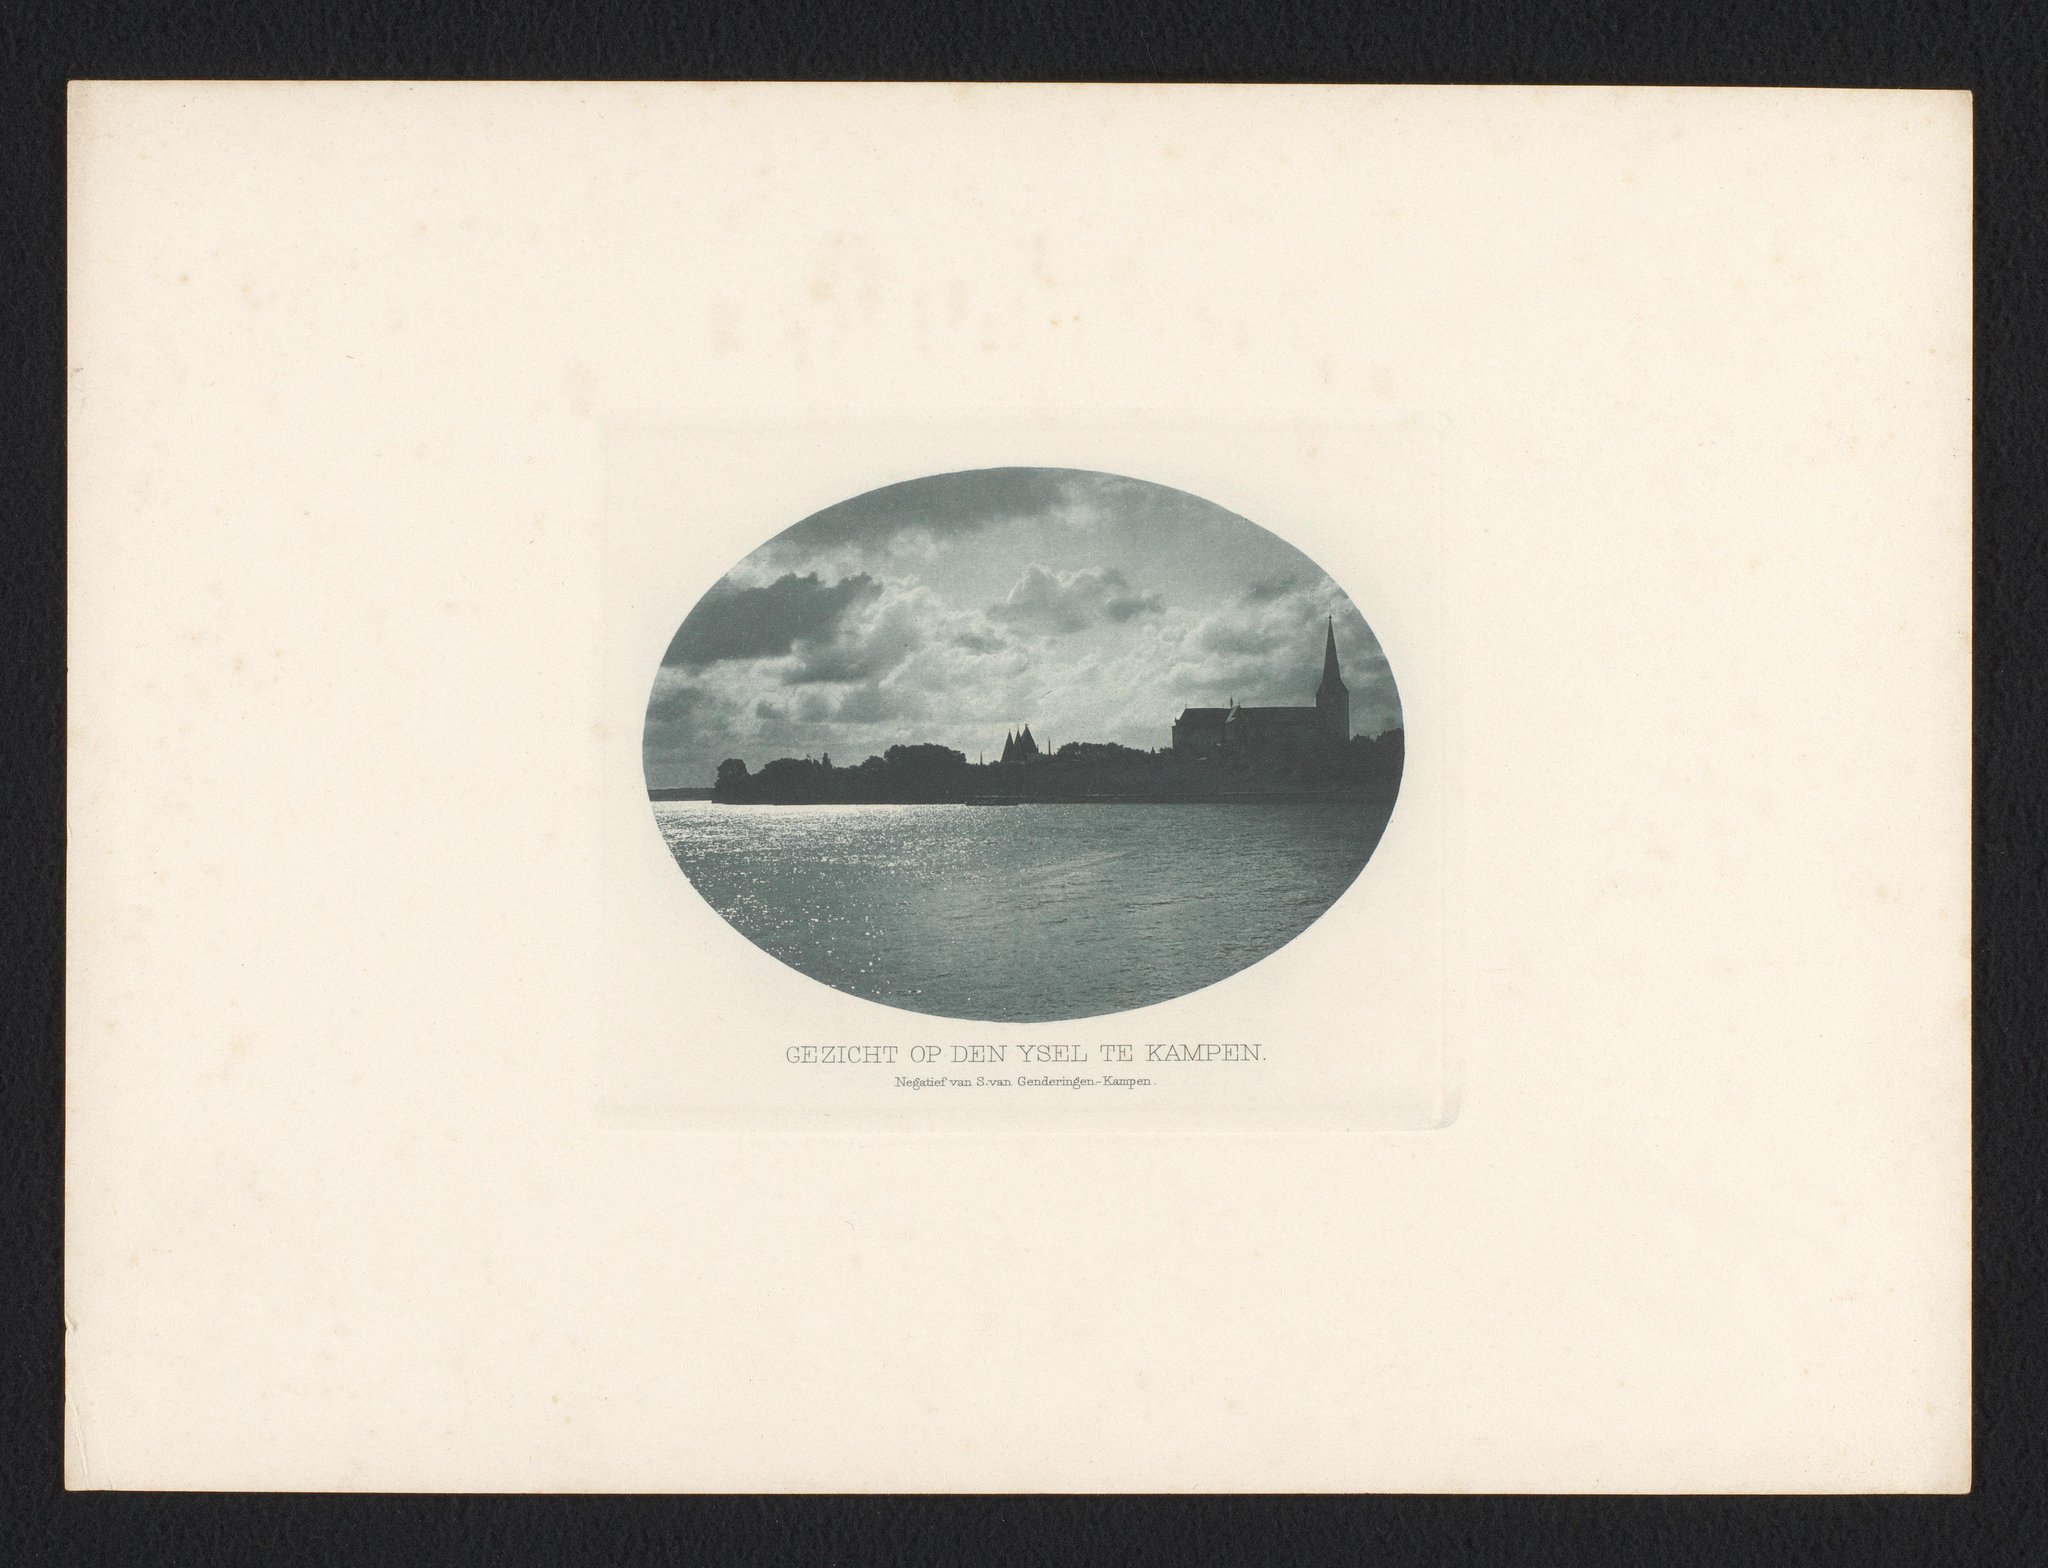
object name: page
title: Gezicht op de IJssel bij Kampen, rechts de Bovenkerk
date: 1898-1903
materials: paper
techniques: photoaquatint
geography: kampen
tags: city-view in general; 'veduta', river, interior of church